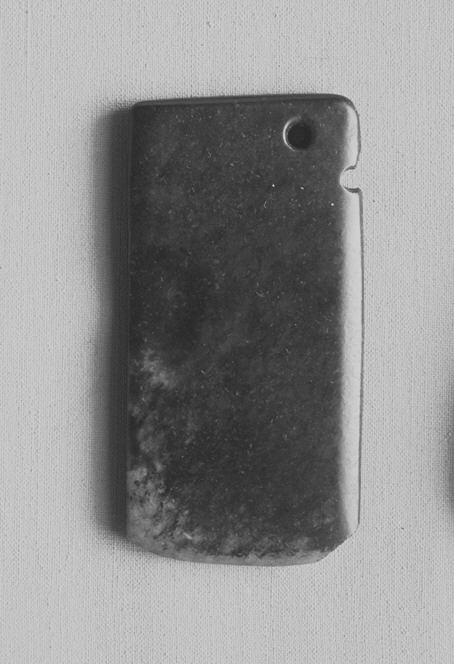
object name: fragment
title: Fragment of a blade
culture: chinese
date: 2000-1500 BCE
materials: jade